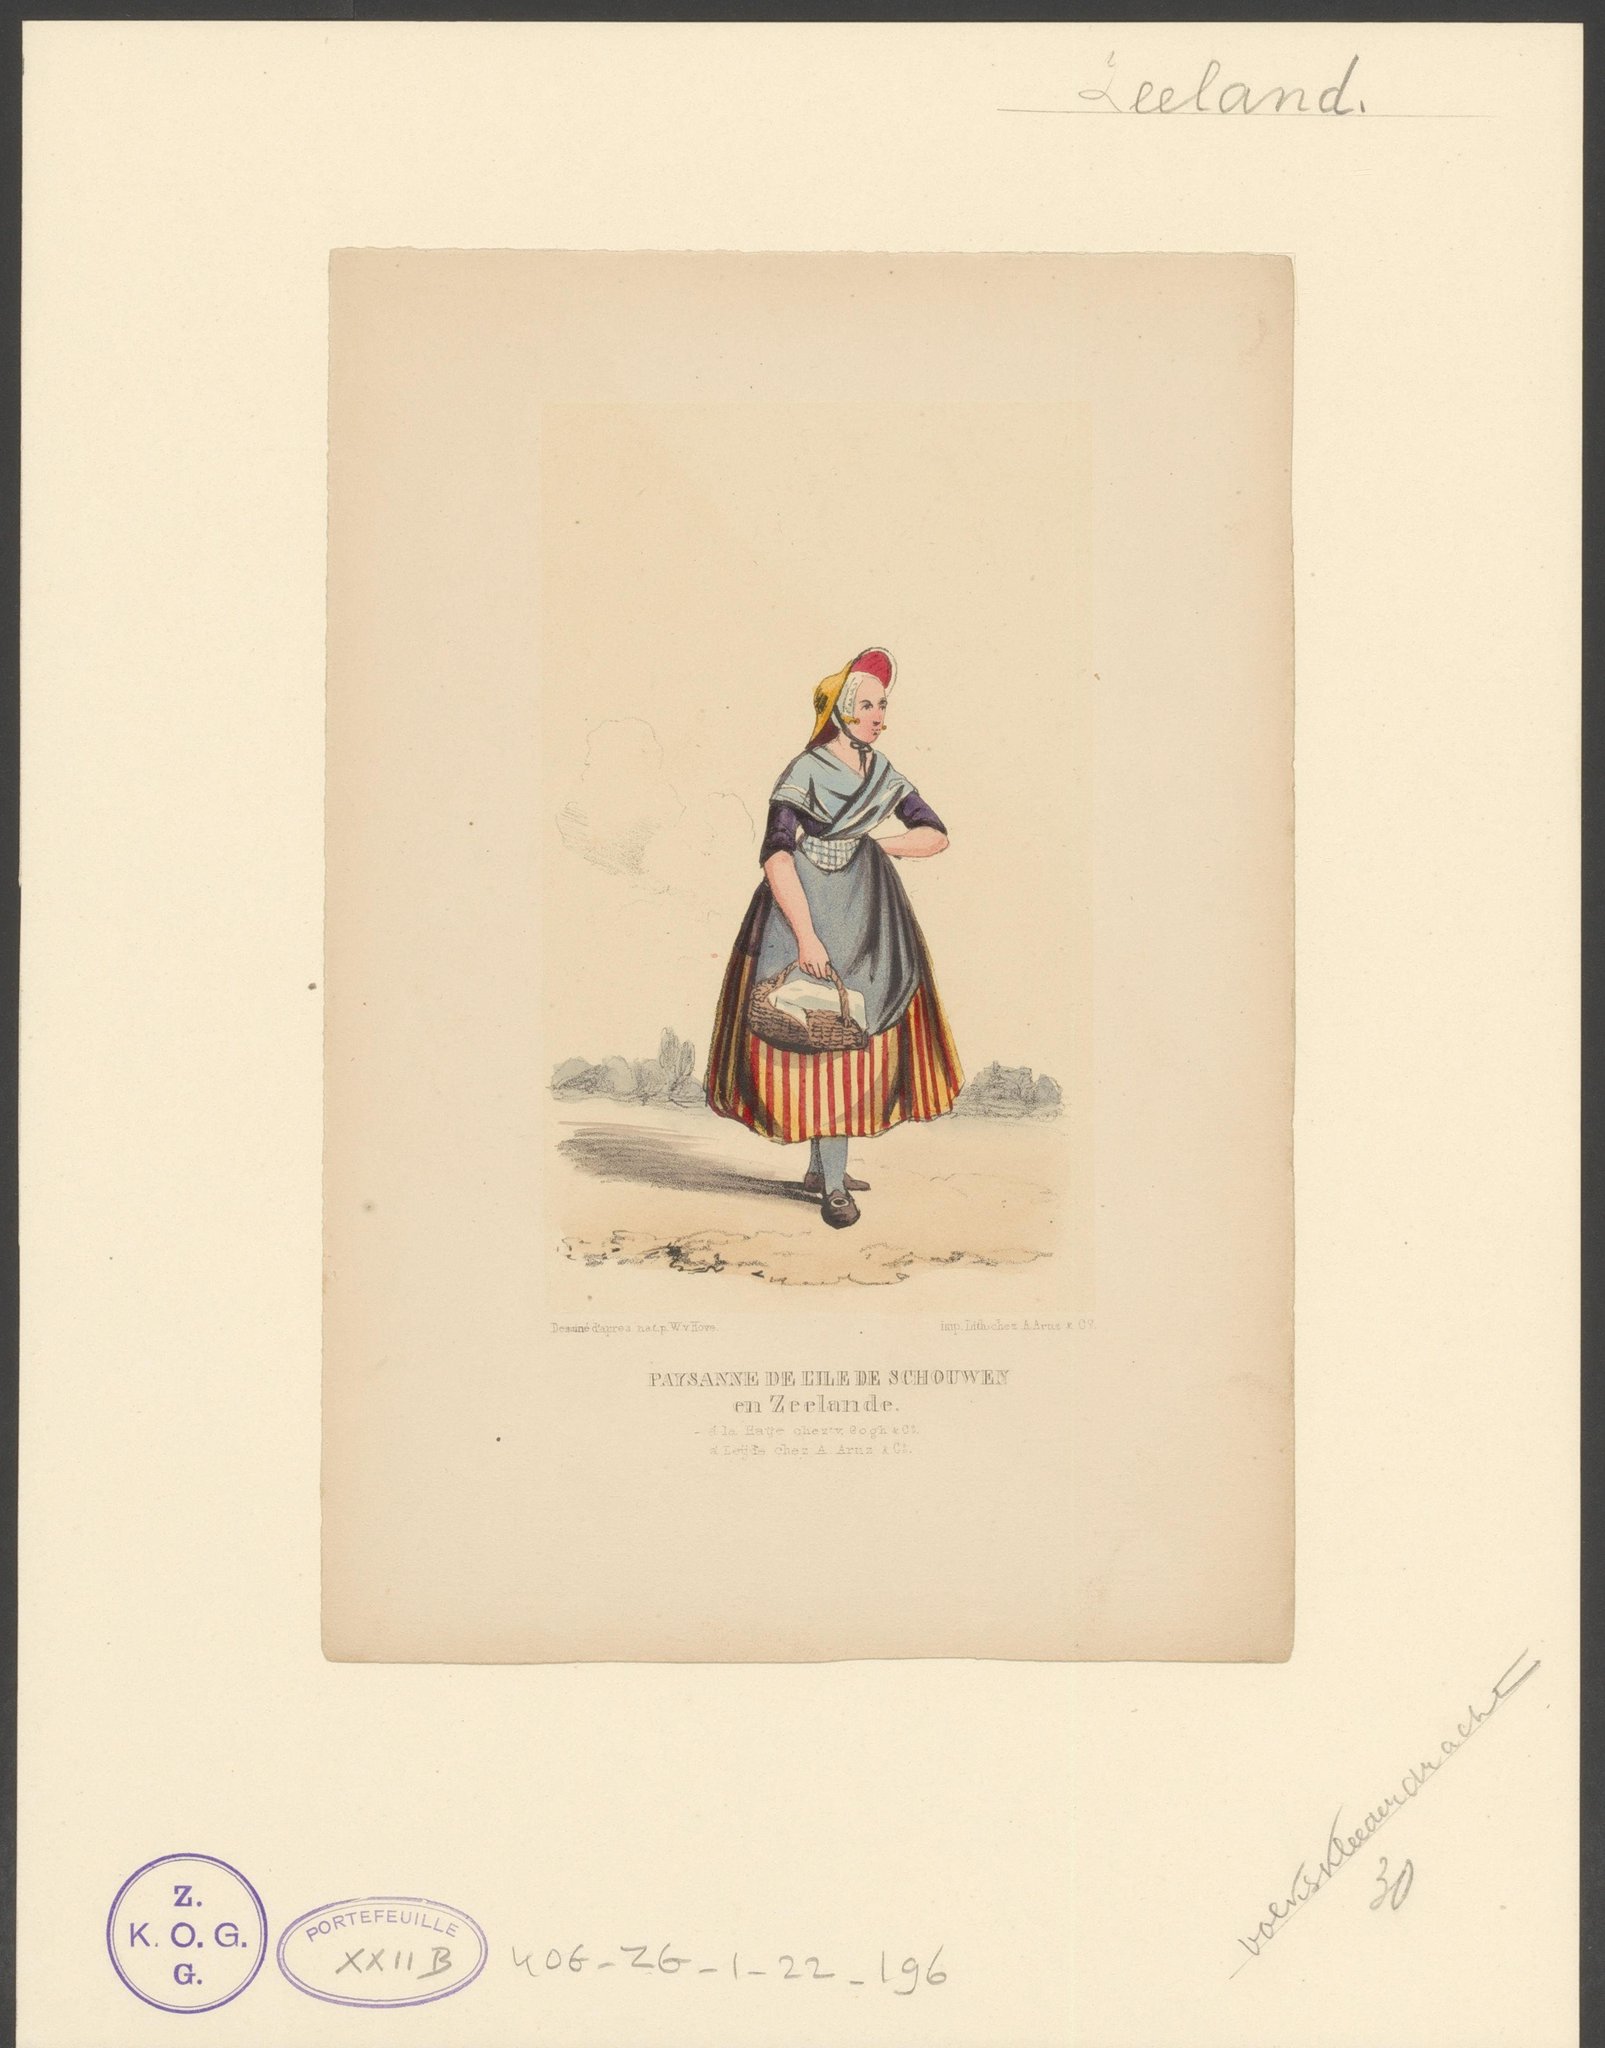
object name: print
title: Paysanne de l'ile de Schouwen en Zeelande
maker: w. van hove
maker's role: draughtsman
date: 1840-1853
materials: paper, watercolor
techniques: hand coloring, lithograph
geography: leiden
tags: clothes, costume (+ women's clothes), folk costume, regional costume, zeeland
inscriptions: collector's mark: Lugt 1641, collector's mark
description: Boerin van het eiland Schouwen, staande met een mand in de hand. Onderwerpsrubrieken binnen de Atlas Zeden en Gewoonten: De Kleeding, Volkskleederdracht, Zeeland.